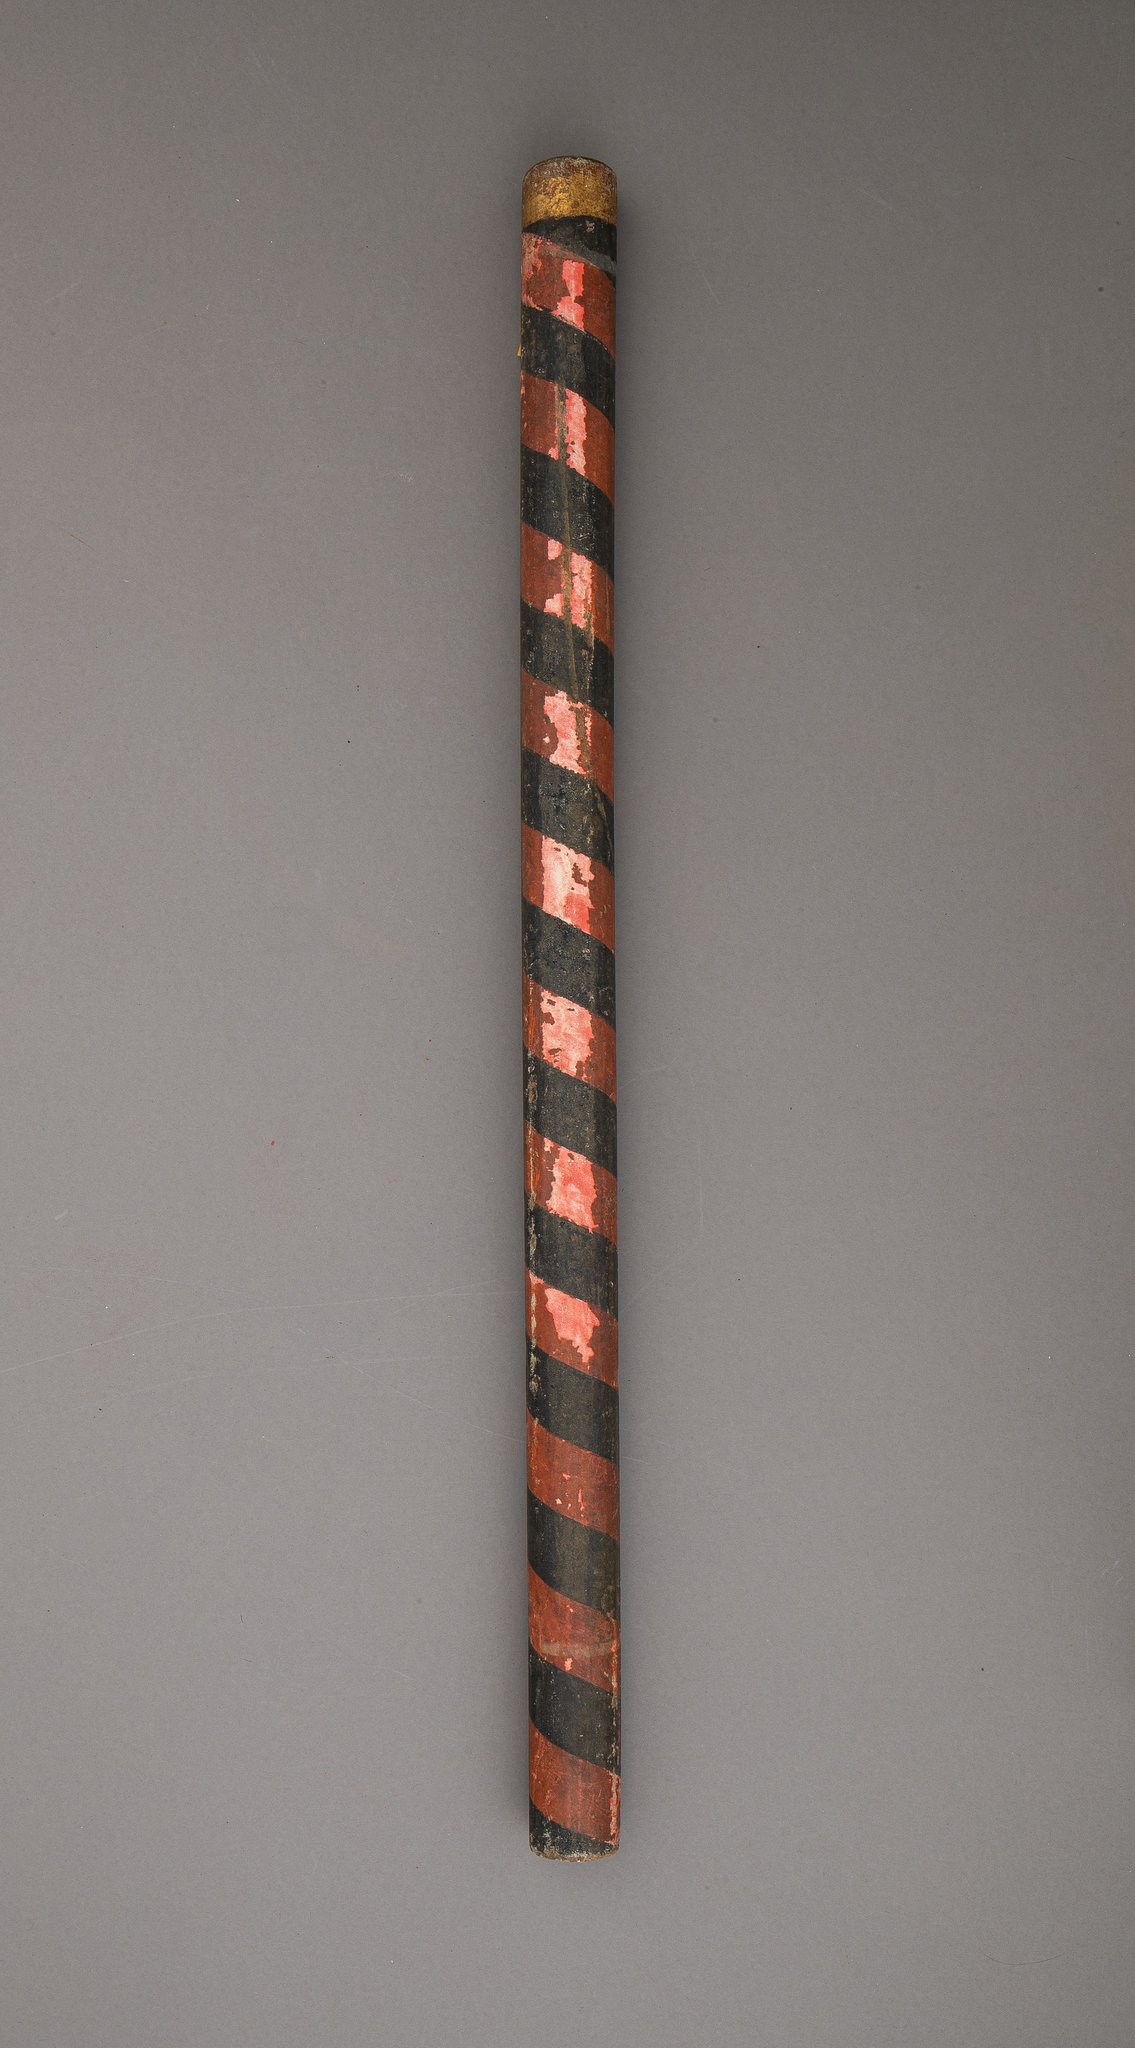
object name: baton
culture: italian, tuscany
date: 1701-1800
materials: wood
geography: italy